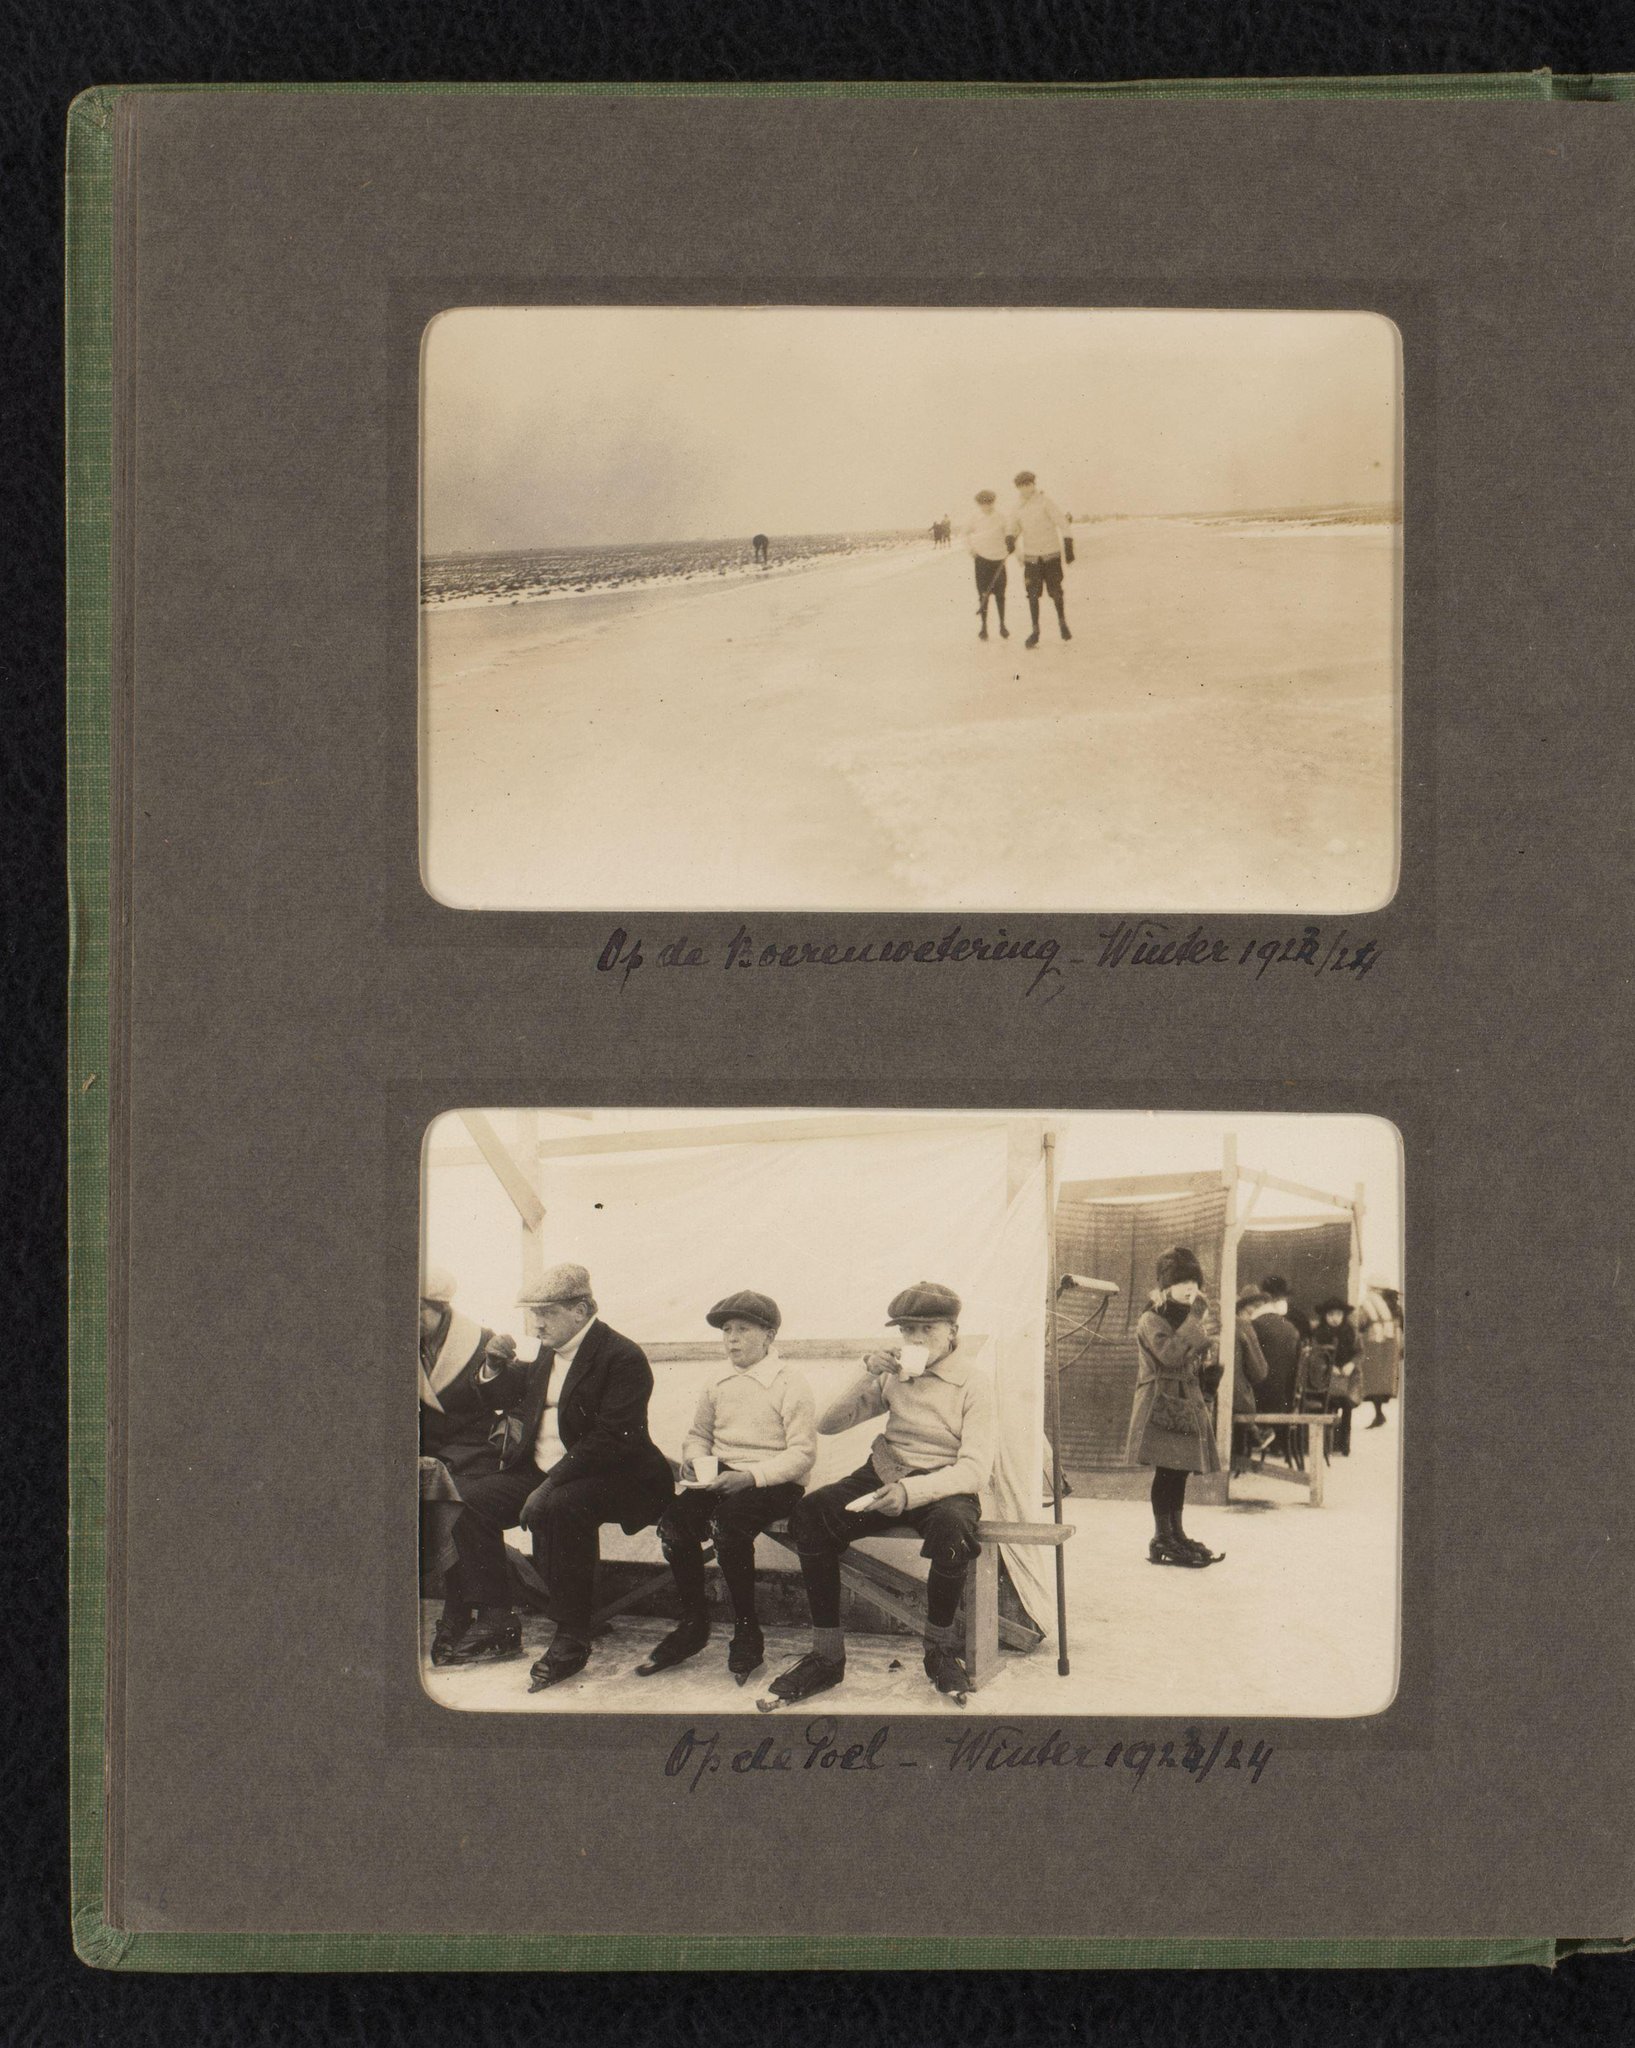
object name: album leaf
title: Twee foto's van schaatsers op de Boerenwetering, Amsterdam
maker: hendrik herman van den berg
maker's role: amateurfotograaf, jurist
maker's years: 1875-1944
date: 1923-1924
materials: paper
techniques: gelatin silver print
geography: amsterdam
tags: skates (winter sports)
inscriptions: inscription: ‘Op de Boerenwetering - Winter 1923/24’, inscription: ‘Op de Poel - Winter 1923/24’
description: Deze foto's maken deel uit van een album.